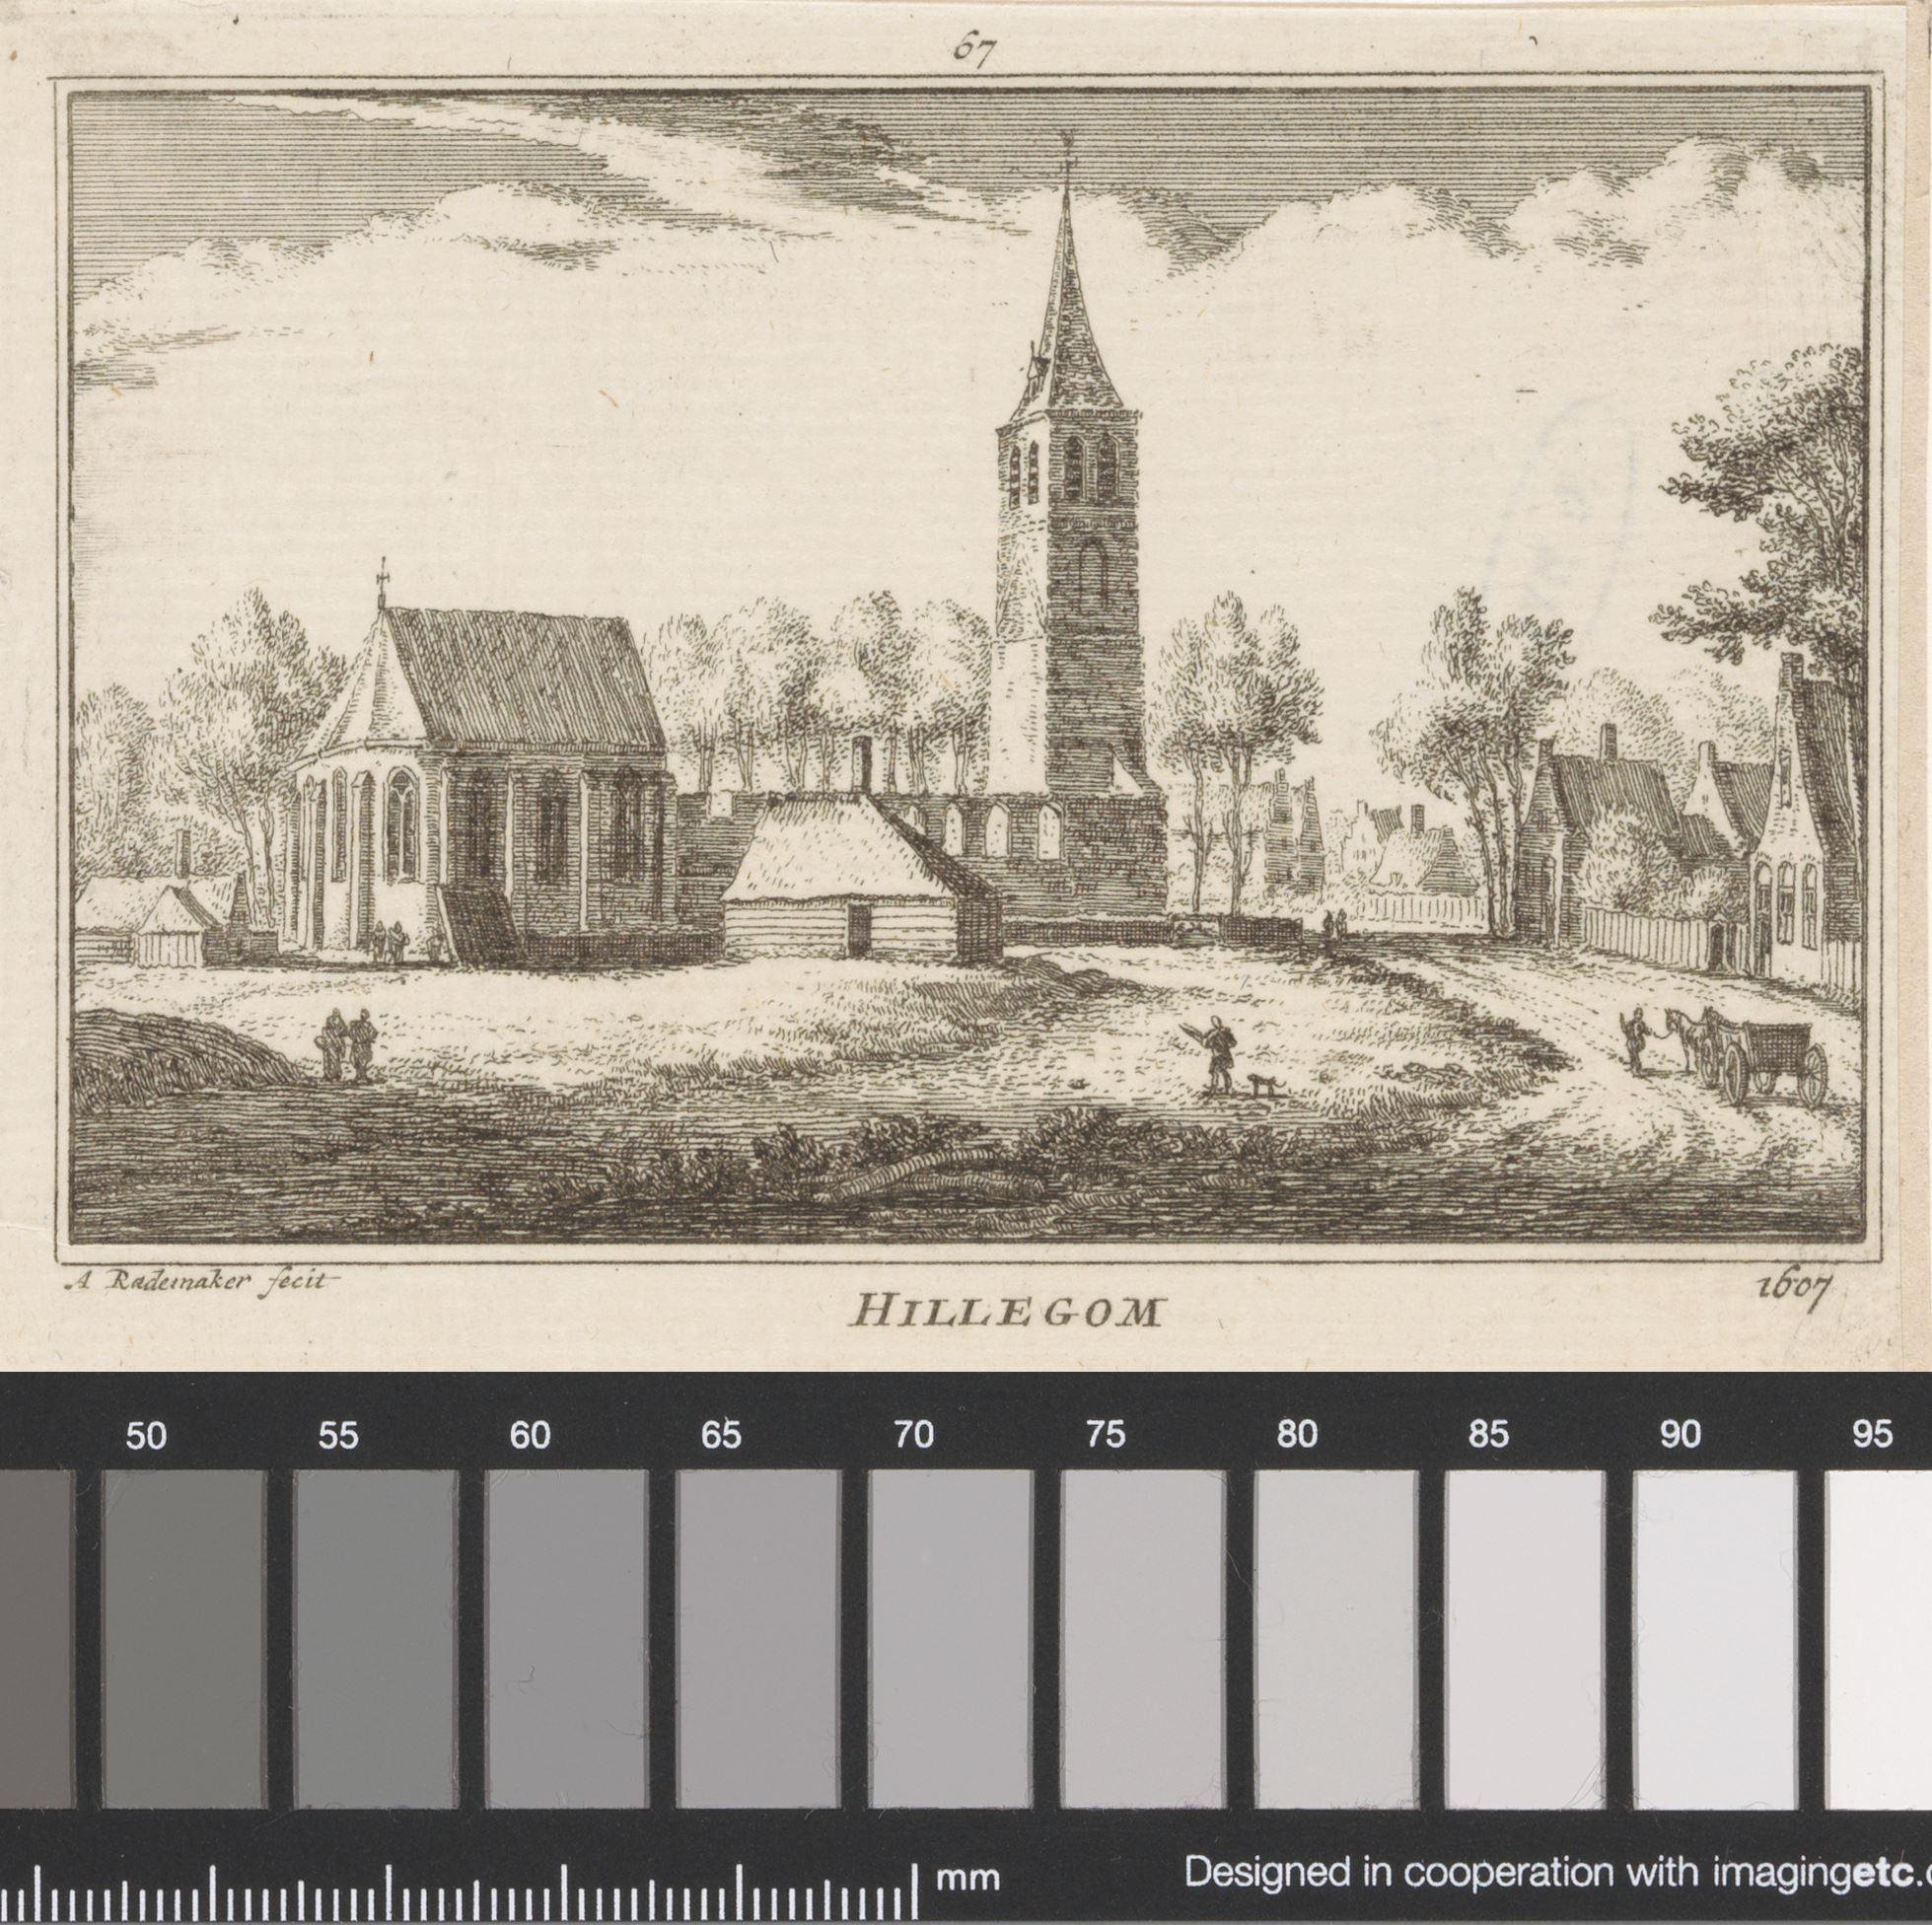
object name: book illustration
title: Gezicht op de Maartenskerk te Hillegom, 1607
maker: abraham rademaker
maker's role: draughtsman, print maker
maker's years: 1676-1735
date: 1725-1803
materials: paper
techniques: engraving, etching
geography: amsterdam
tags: ruin of church, monastery, etc.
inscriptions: collector's mark: Lugt 2228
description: Prent ook gebruikt in: Rademaker, Abraham. Kabinet van Nederlandsche outheden en gezichten: vervat in 300 konstplaaten (…). 2 delen. Amsterdam: Willem Barents, 1725, dl. 1, ill. 67. Na 1725 is deze prent nog in verschillende heruitgaven verschenen, uitgegeven in 1727-1733, 1770-1771 en 1792-1803. Uit welke uitgave het huidige exemplaar precies komt is niet na te gaan.